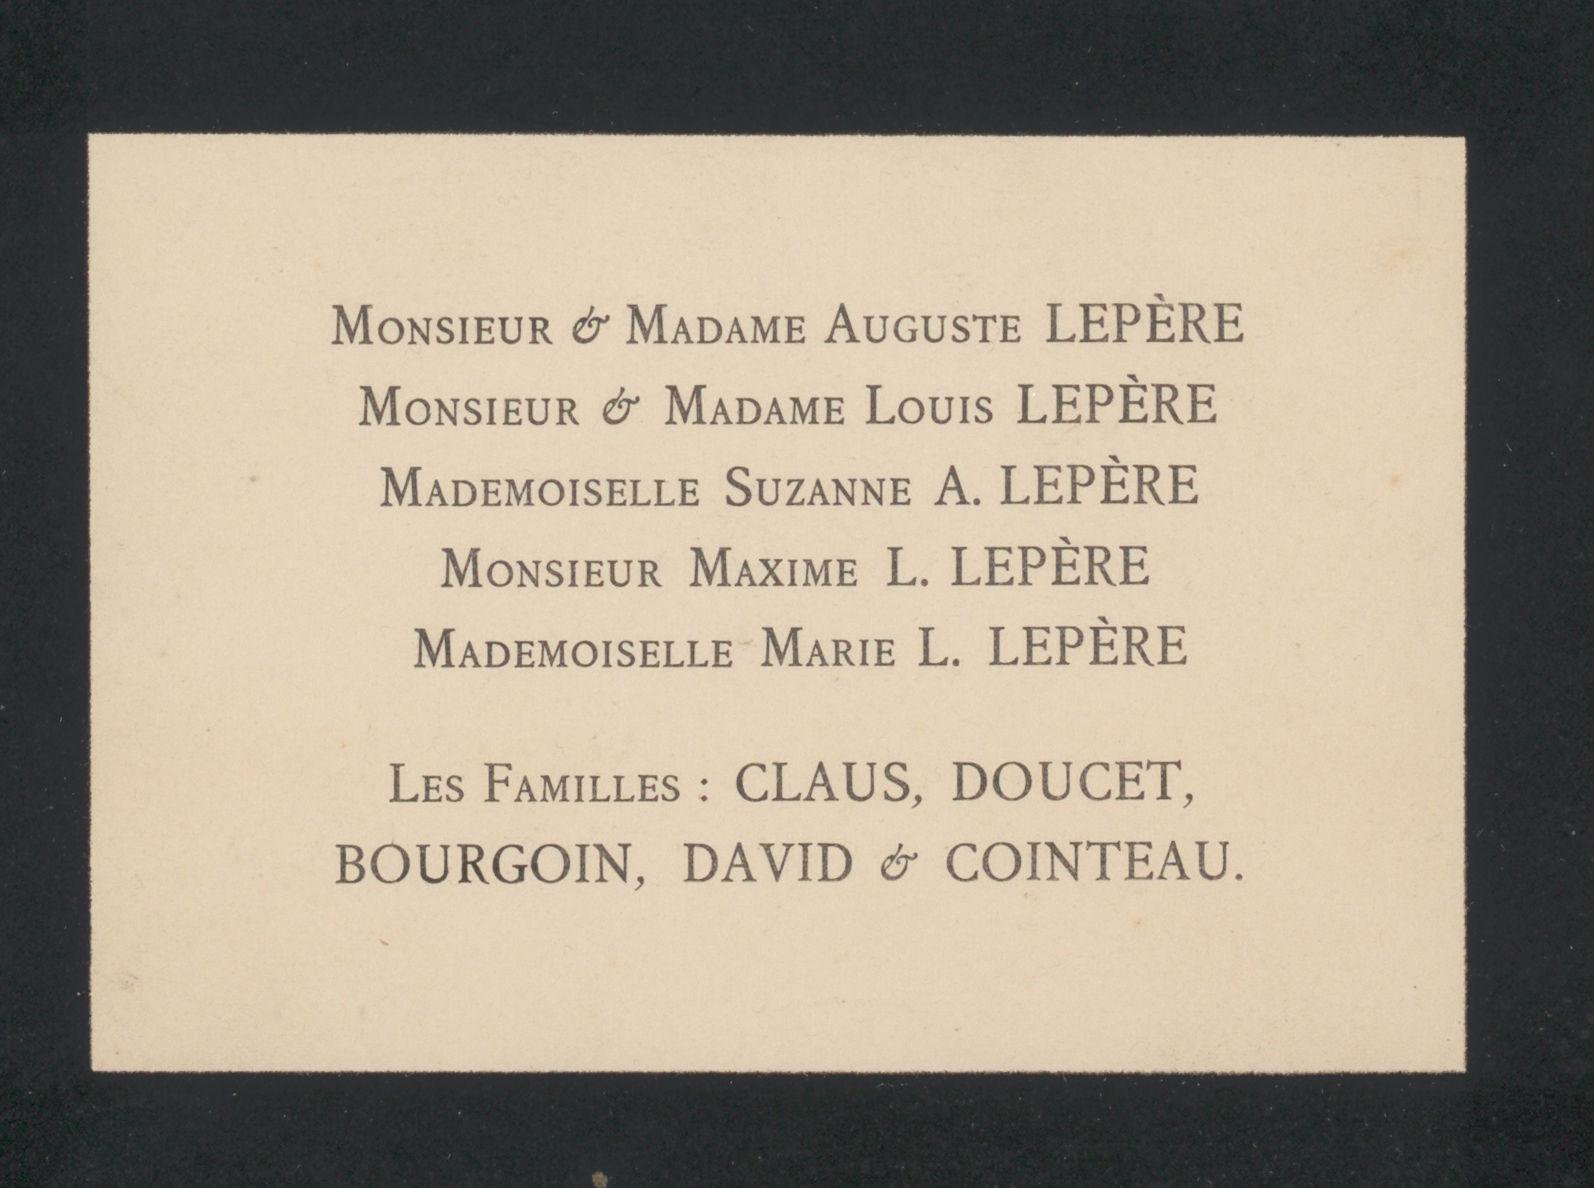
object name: bedankkaart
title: Bedankkaart aan Philip Zilcken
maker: Anonymous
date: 1867-1918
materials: cardboard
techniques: printing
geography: paris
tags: paris, print maker, auguste lepère, painter, draughtsman, philip zilcken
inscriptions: collector's mark: ‘RPK’